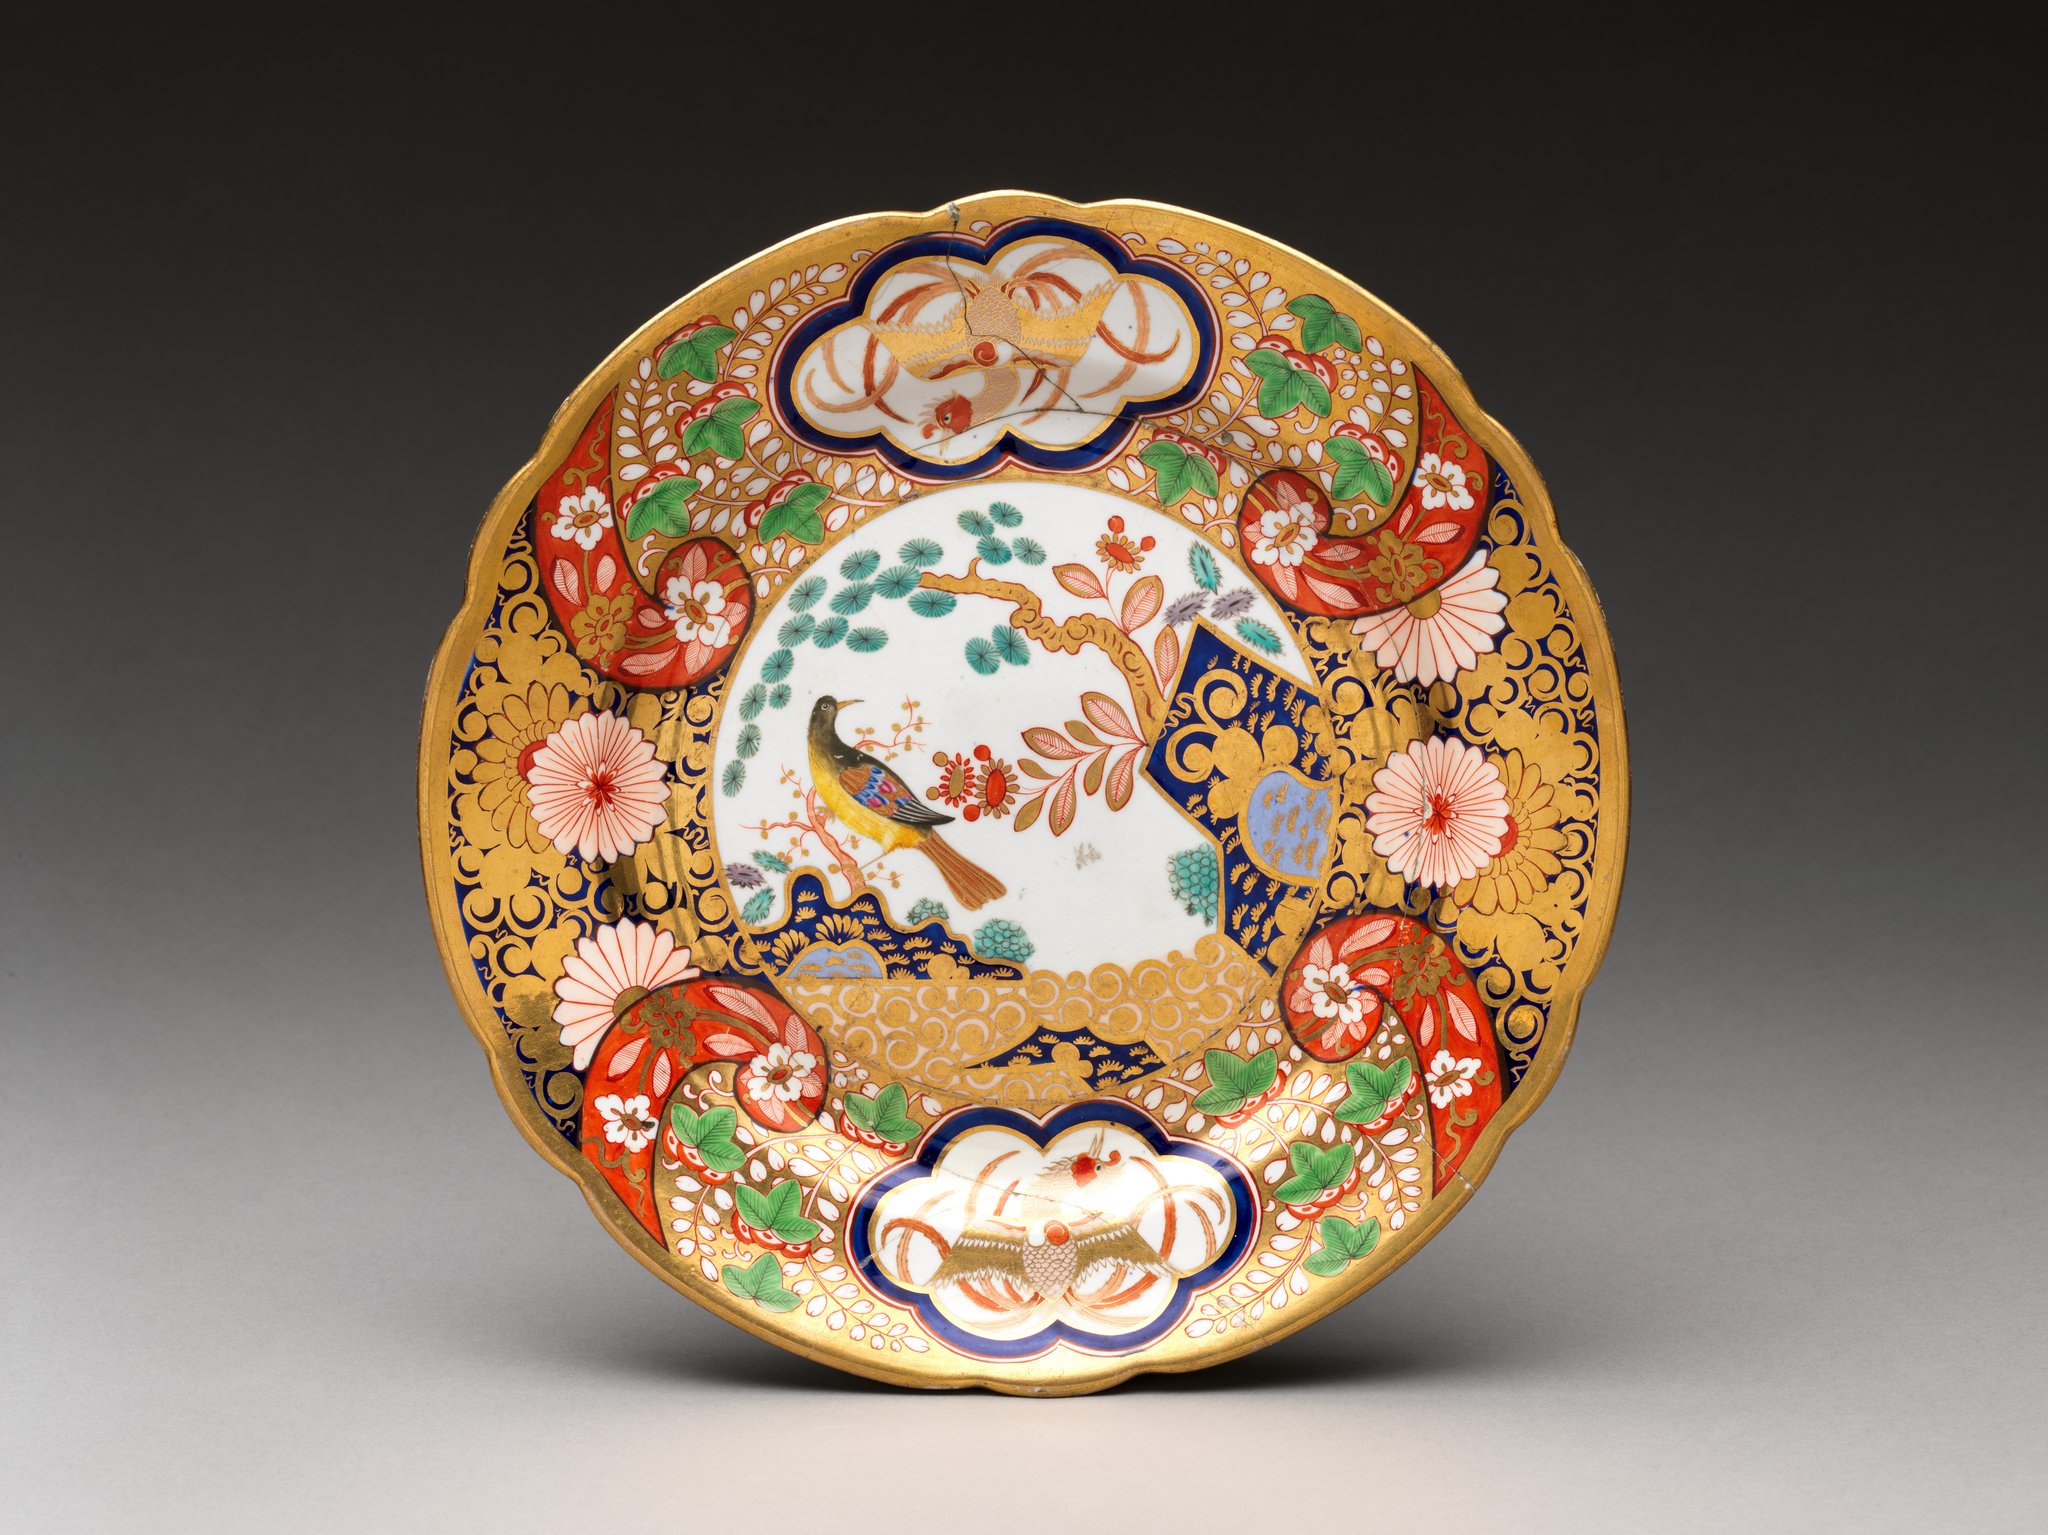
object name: plate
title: Plate with rocks, flowers, and birds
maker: j. spode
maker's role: factory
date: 1815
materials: bone, enamel, glaze, porcelain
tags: birds,flowers